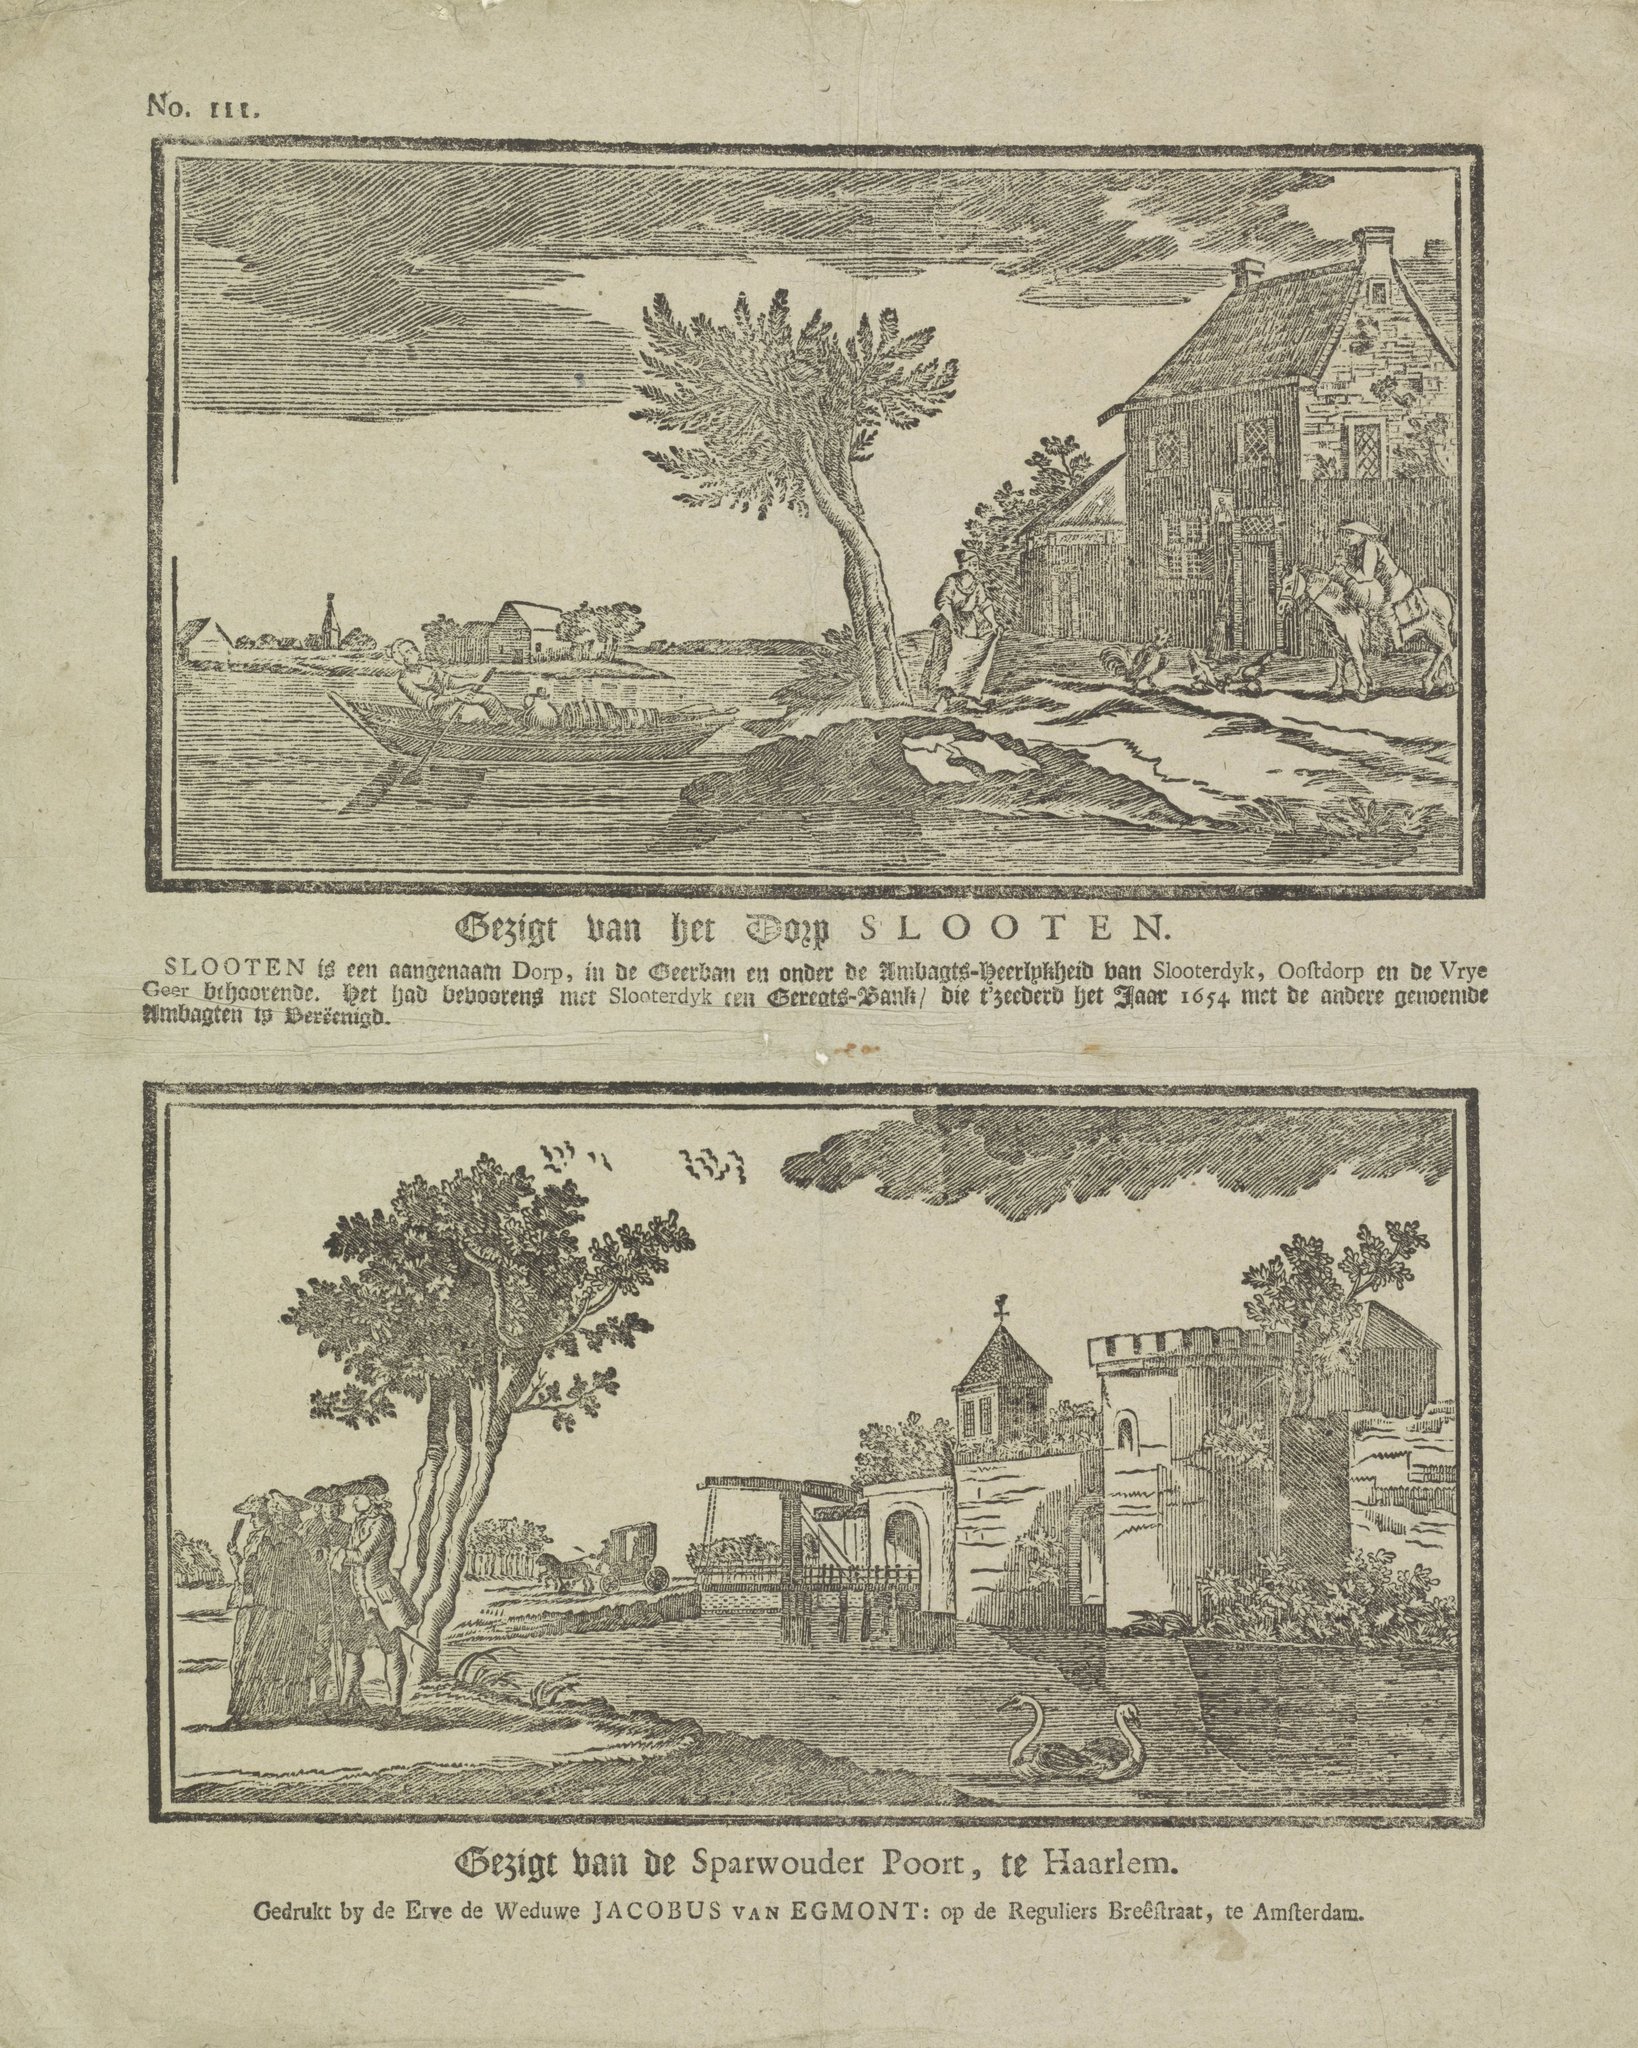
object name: print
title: Gezigt van het dorp Slooten / Gezigt van de Sparwouder Poort, te Haarlem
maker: Anonymous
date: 1761-1804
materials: paper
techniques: letterpress printing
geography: amsterdam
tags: city-view, and landscape with man-made constructions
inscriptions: collector's mark: Lugt 2760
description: Blad met 2 voorstelling. Boven: een gezicht op Sloten. Onder: een gezicht op de Spaarnwouderpoort te Haarlem. Onder elke voorstelling een titel en een onderschrift. Genummerd linksboven: No. 111.